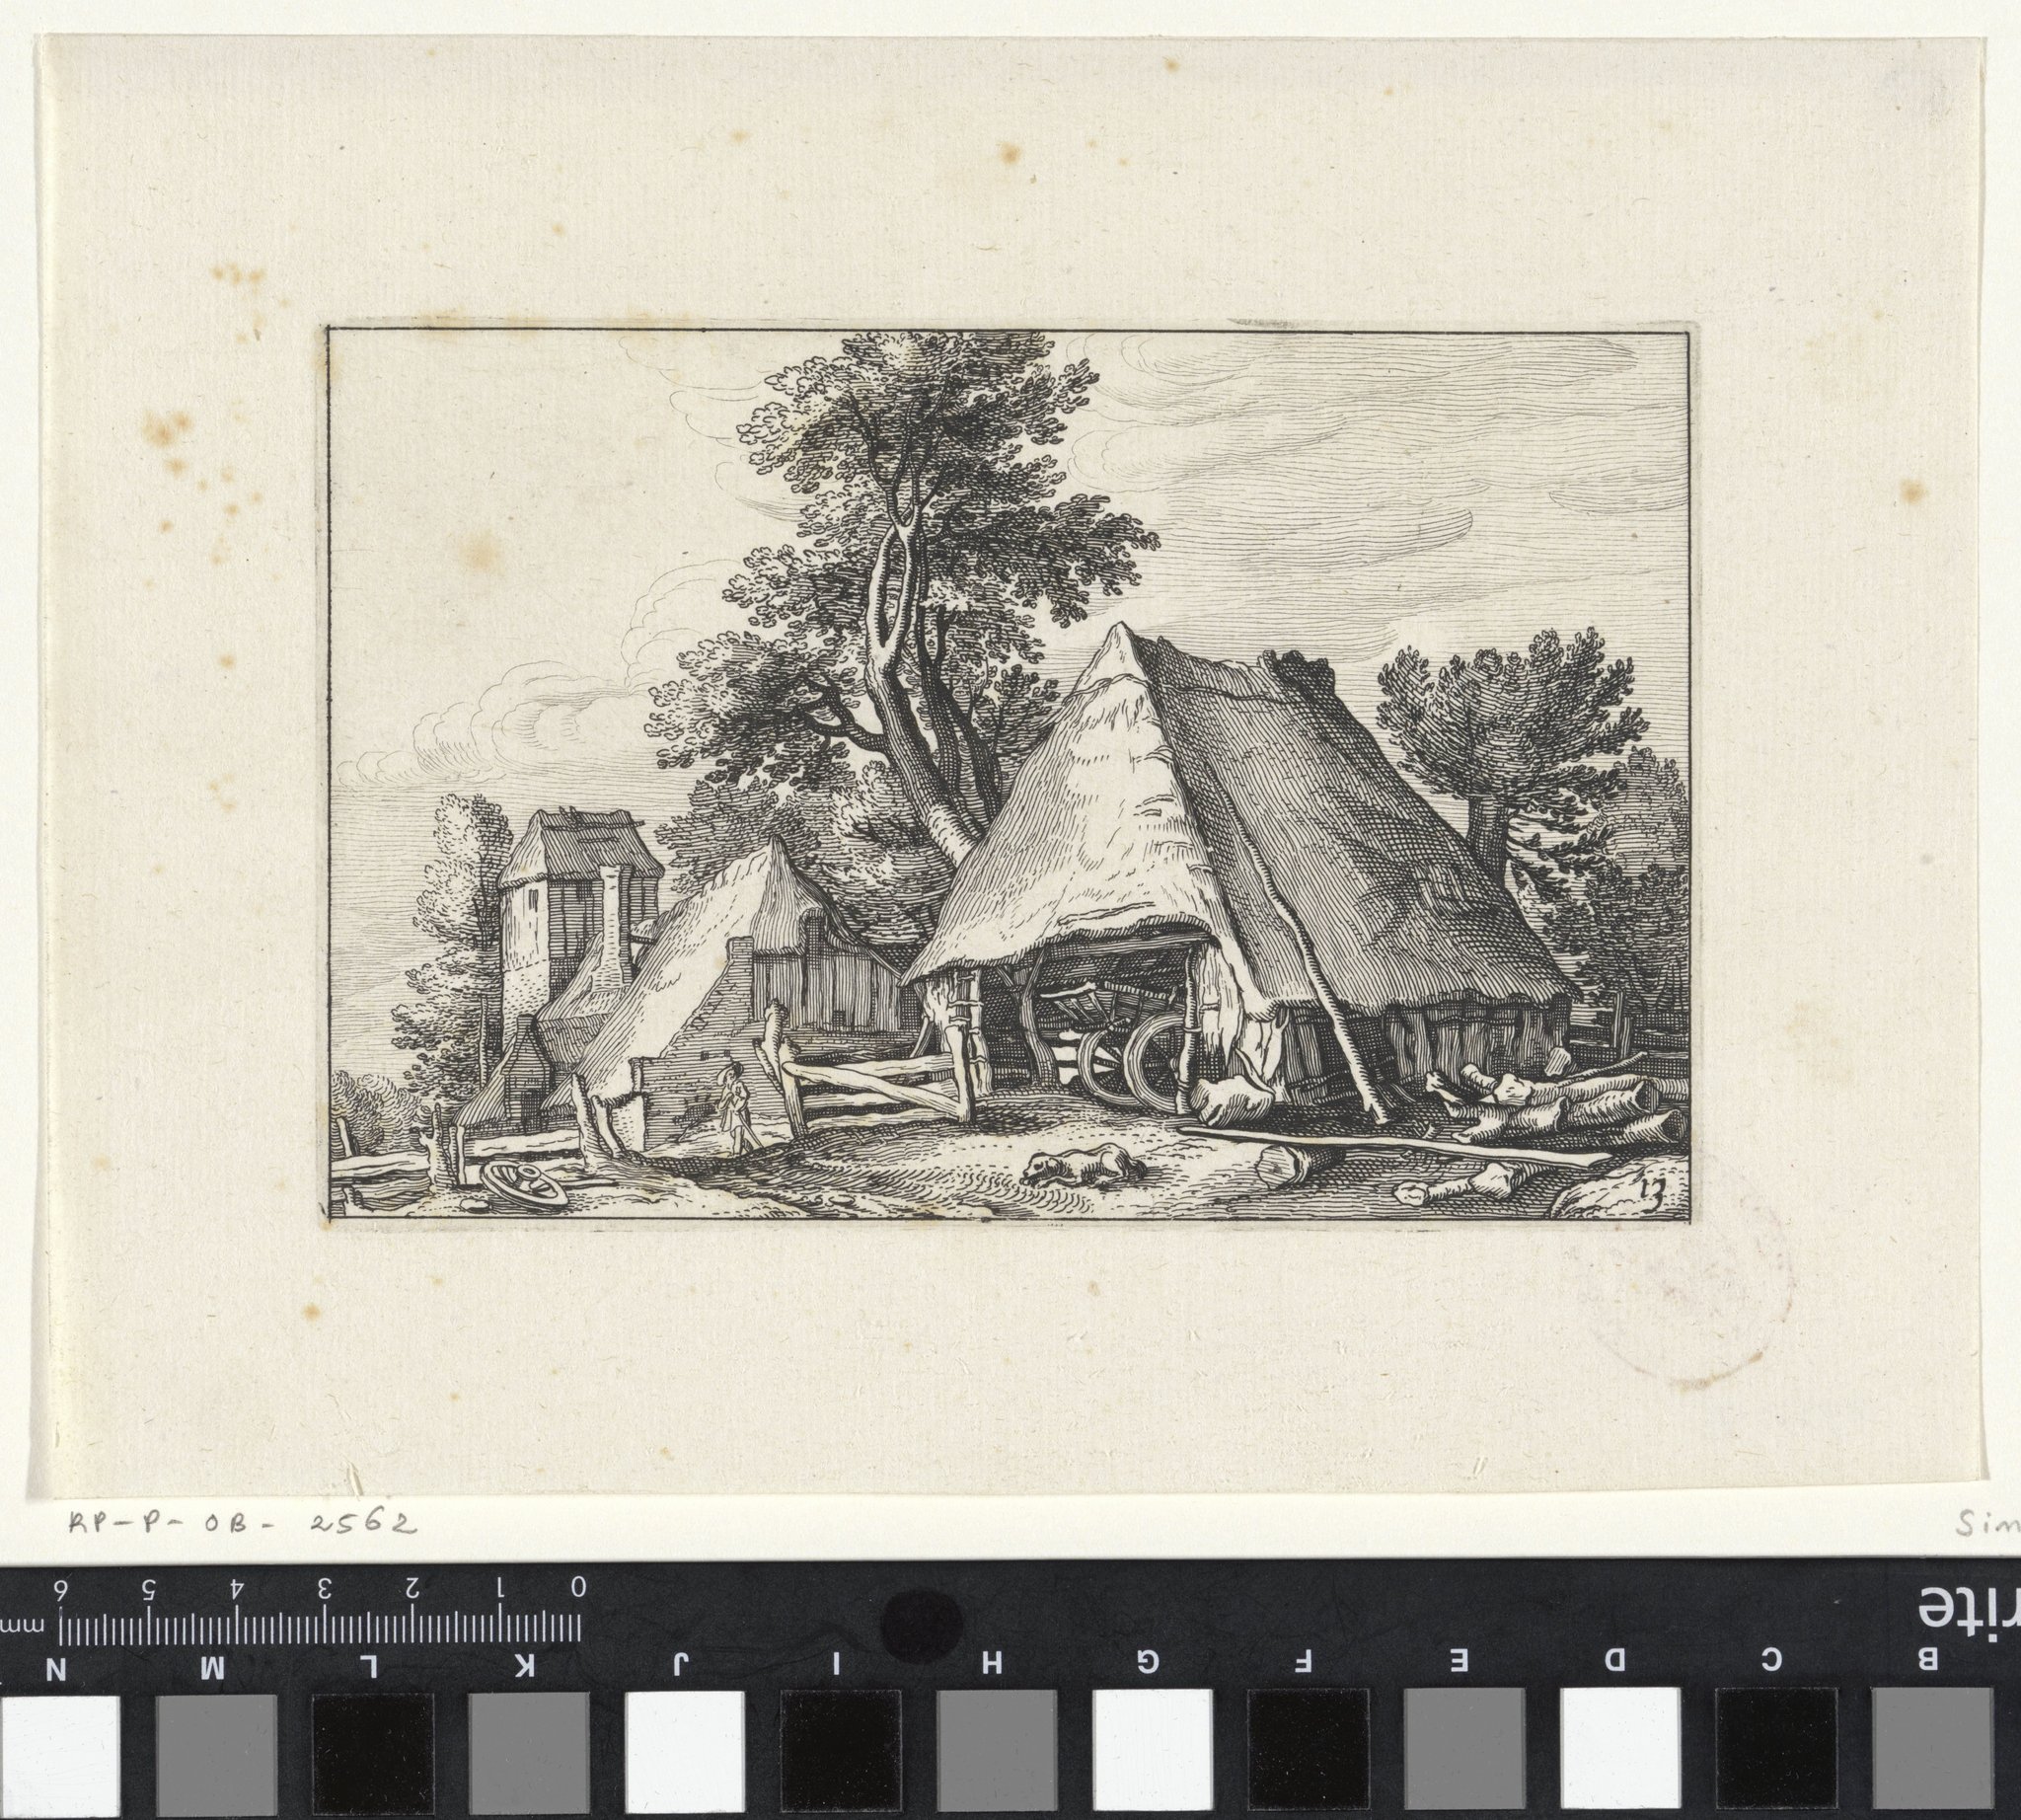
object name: print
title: Boerderij tussen het geboomte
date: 1620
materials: paper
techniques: etching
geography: amsterdam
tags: trees, shed, farm (building)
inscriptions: collector's mark: Lugt 240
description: Tussen het geboomte liggen een schuur en een boerderij. In de schuur staat een kar.